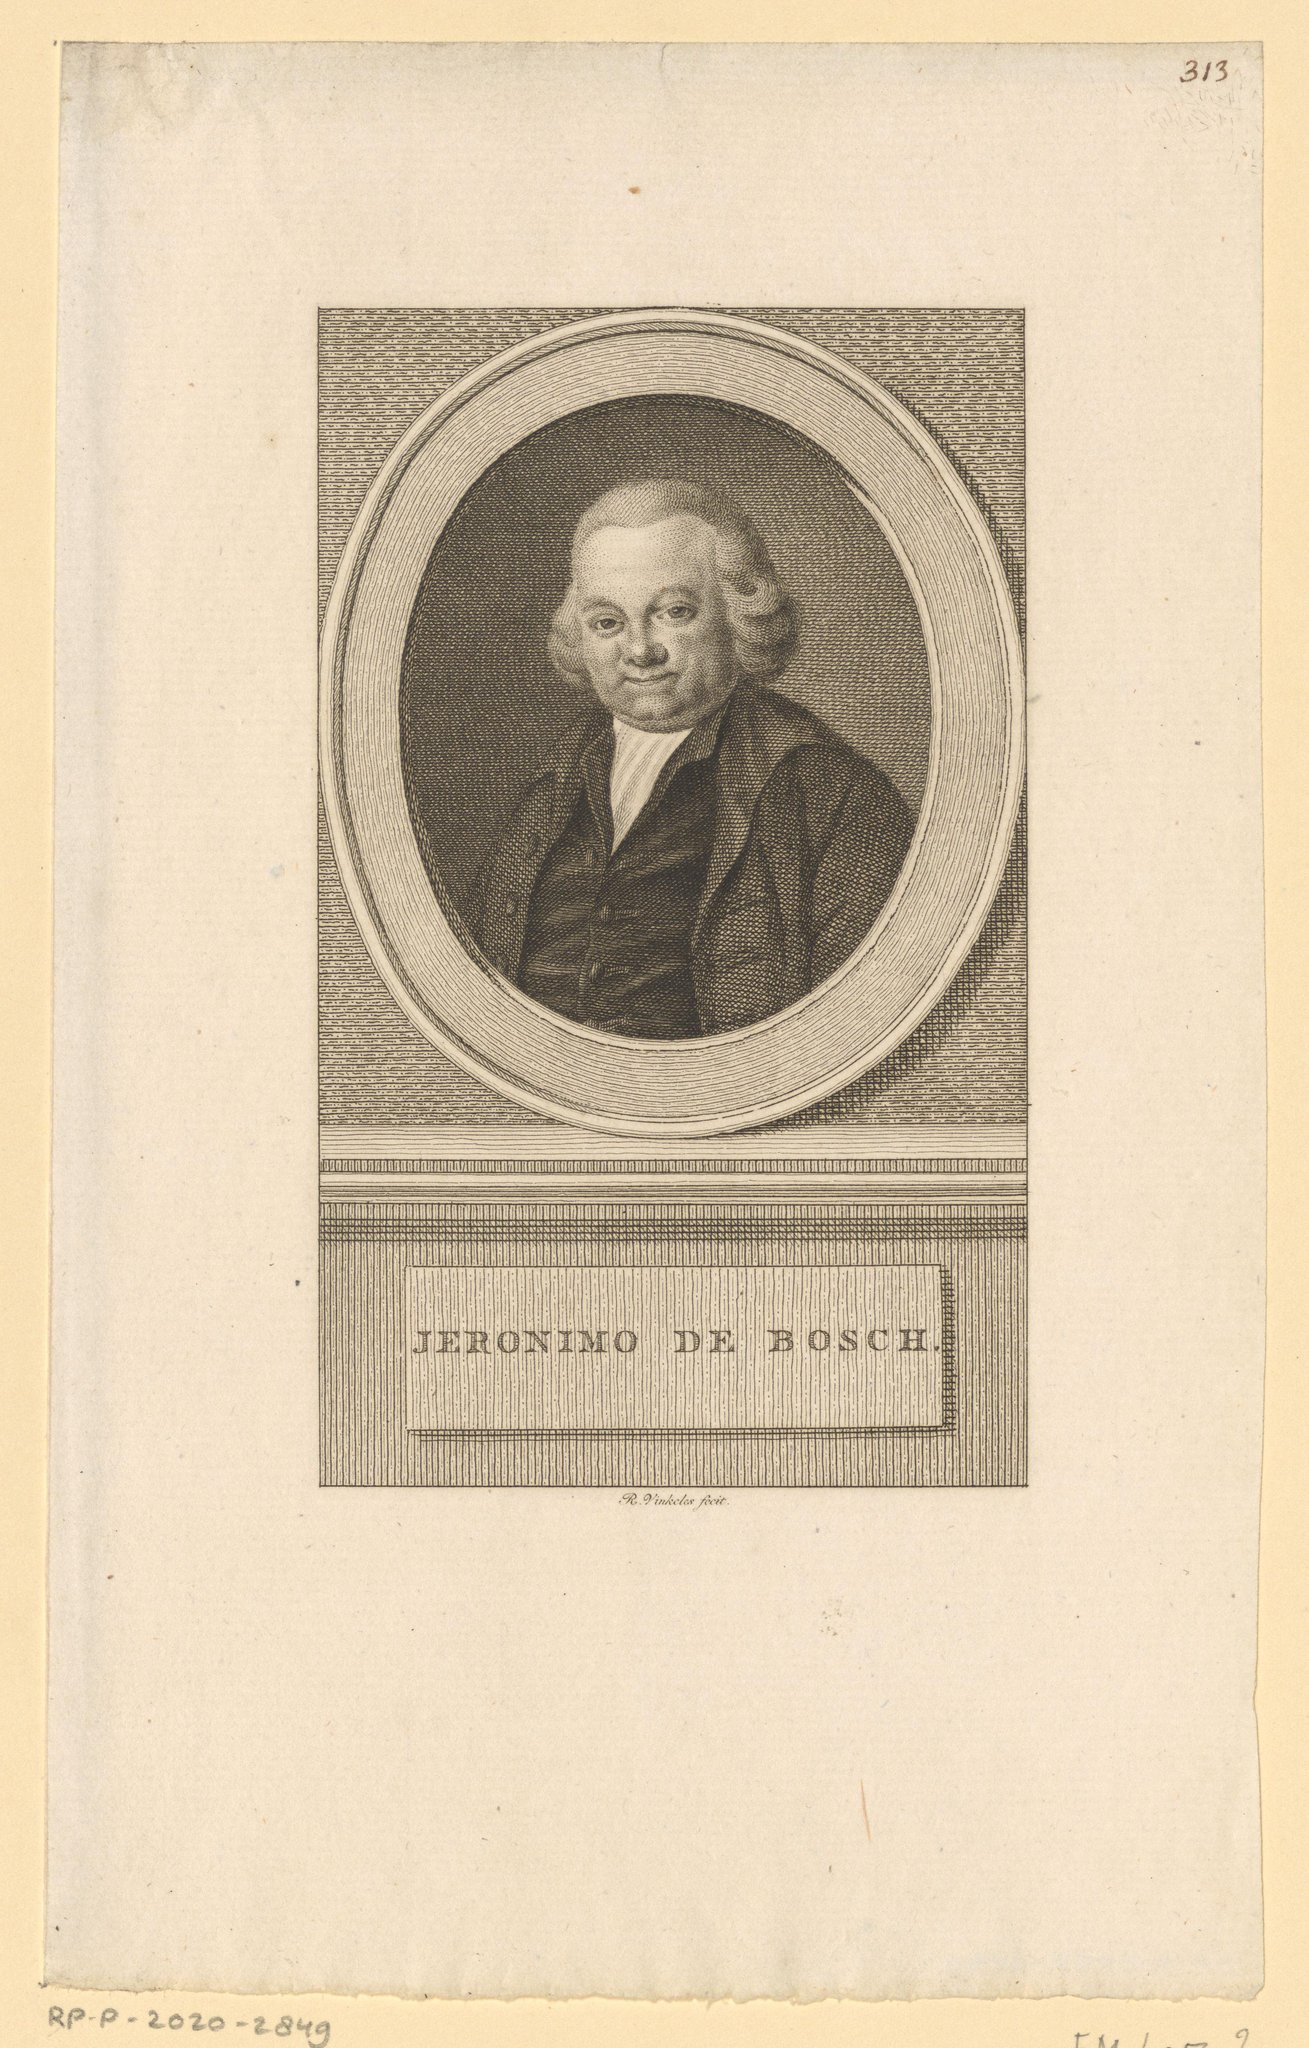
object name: book illustration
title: Portret van Jeronimo de Bosch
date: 1786-1811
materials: paper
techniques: engraving, etching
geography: amsterdam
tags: amsterdam, jeronimo de bosch, historical persons, writer, poet, author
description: Prent uit: Loosjes, Petrus. Vaderlandsche historie, (...) ten vervolge van Wagenaars Vaderlandsche historie. Amsterdam: Johannes Allart, 1786-1811, dl. 44.